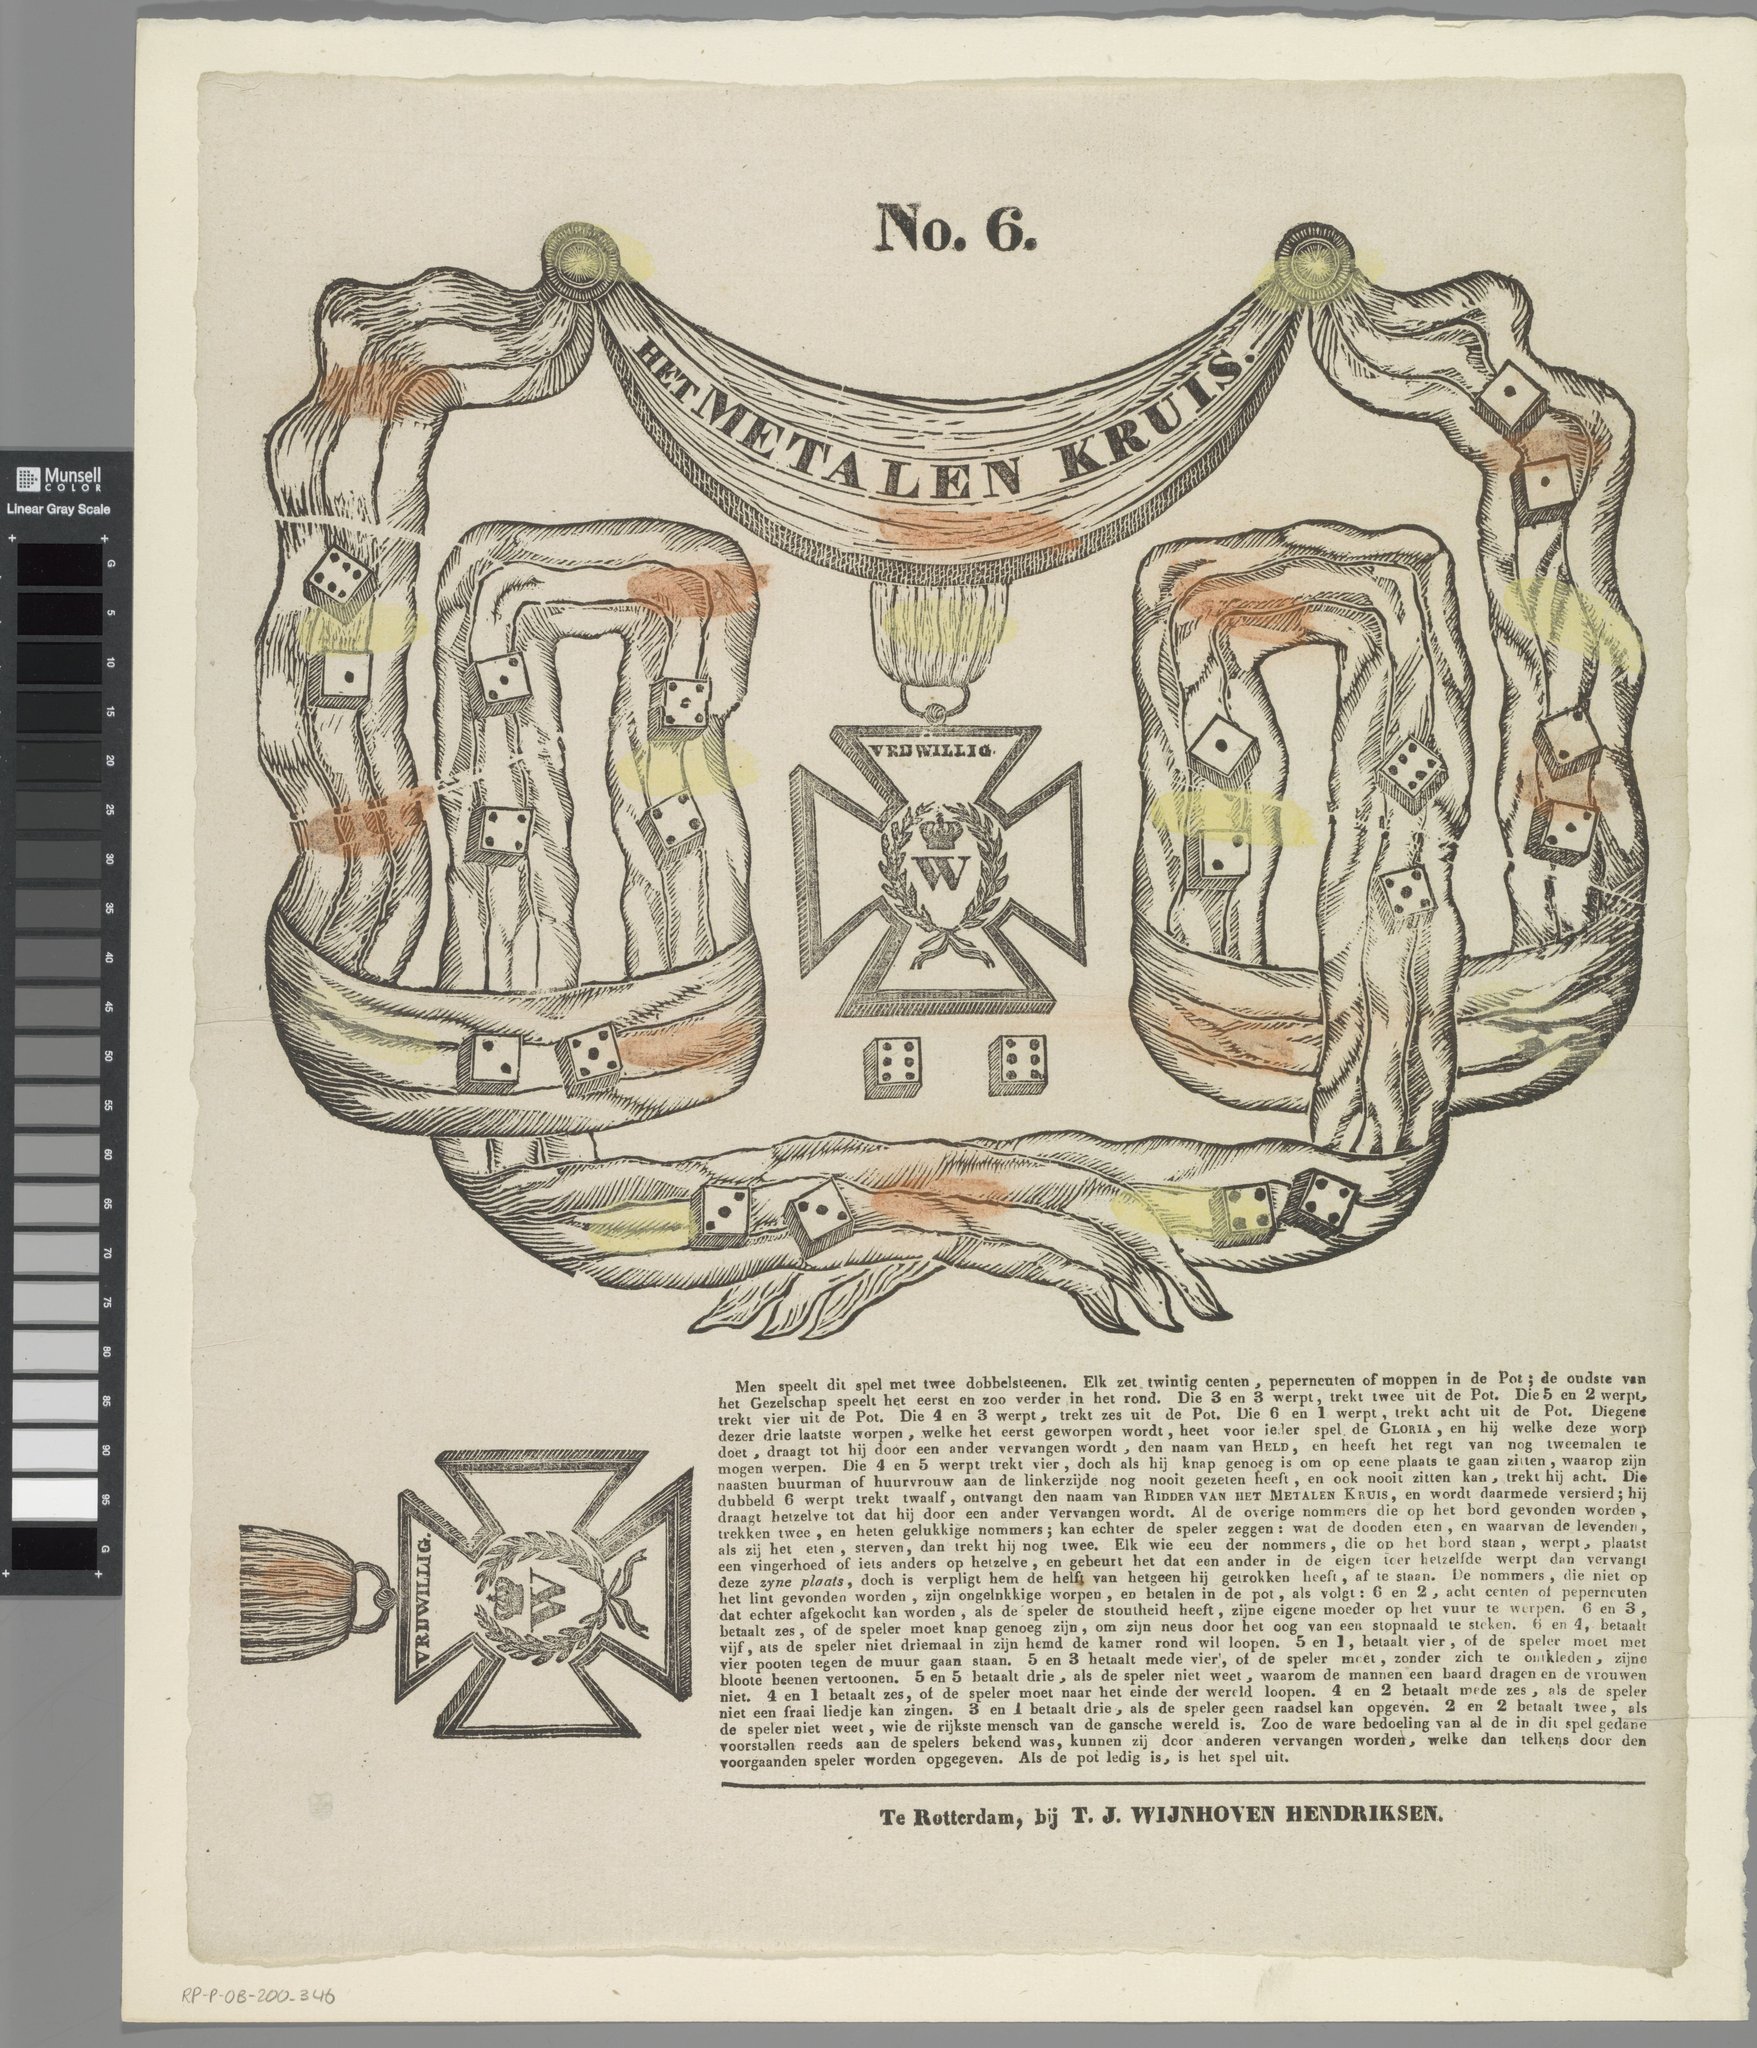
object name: popular print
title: Het metalen kruis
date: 1832-1850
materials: paper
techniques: colour, letterpress printing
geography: rotterdam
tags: board-games of chance, dice-games, dice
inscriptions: collector's mark: Lugt 2760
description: Dobbelspel in de vorm van een vaandel met dobbelstenen, met in het midden het metalen kruis. Onder de voorstelling de spelregels. Genummerd midden boven: No. 6.